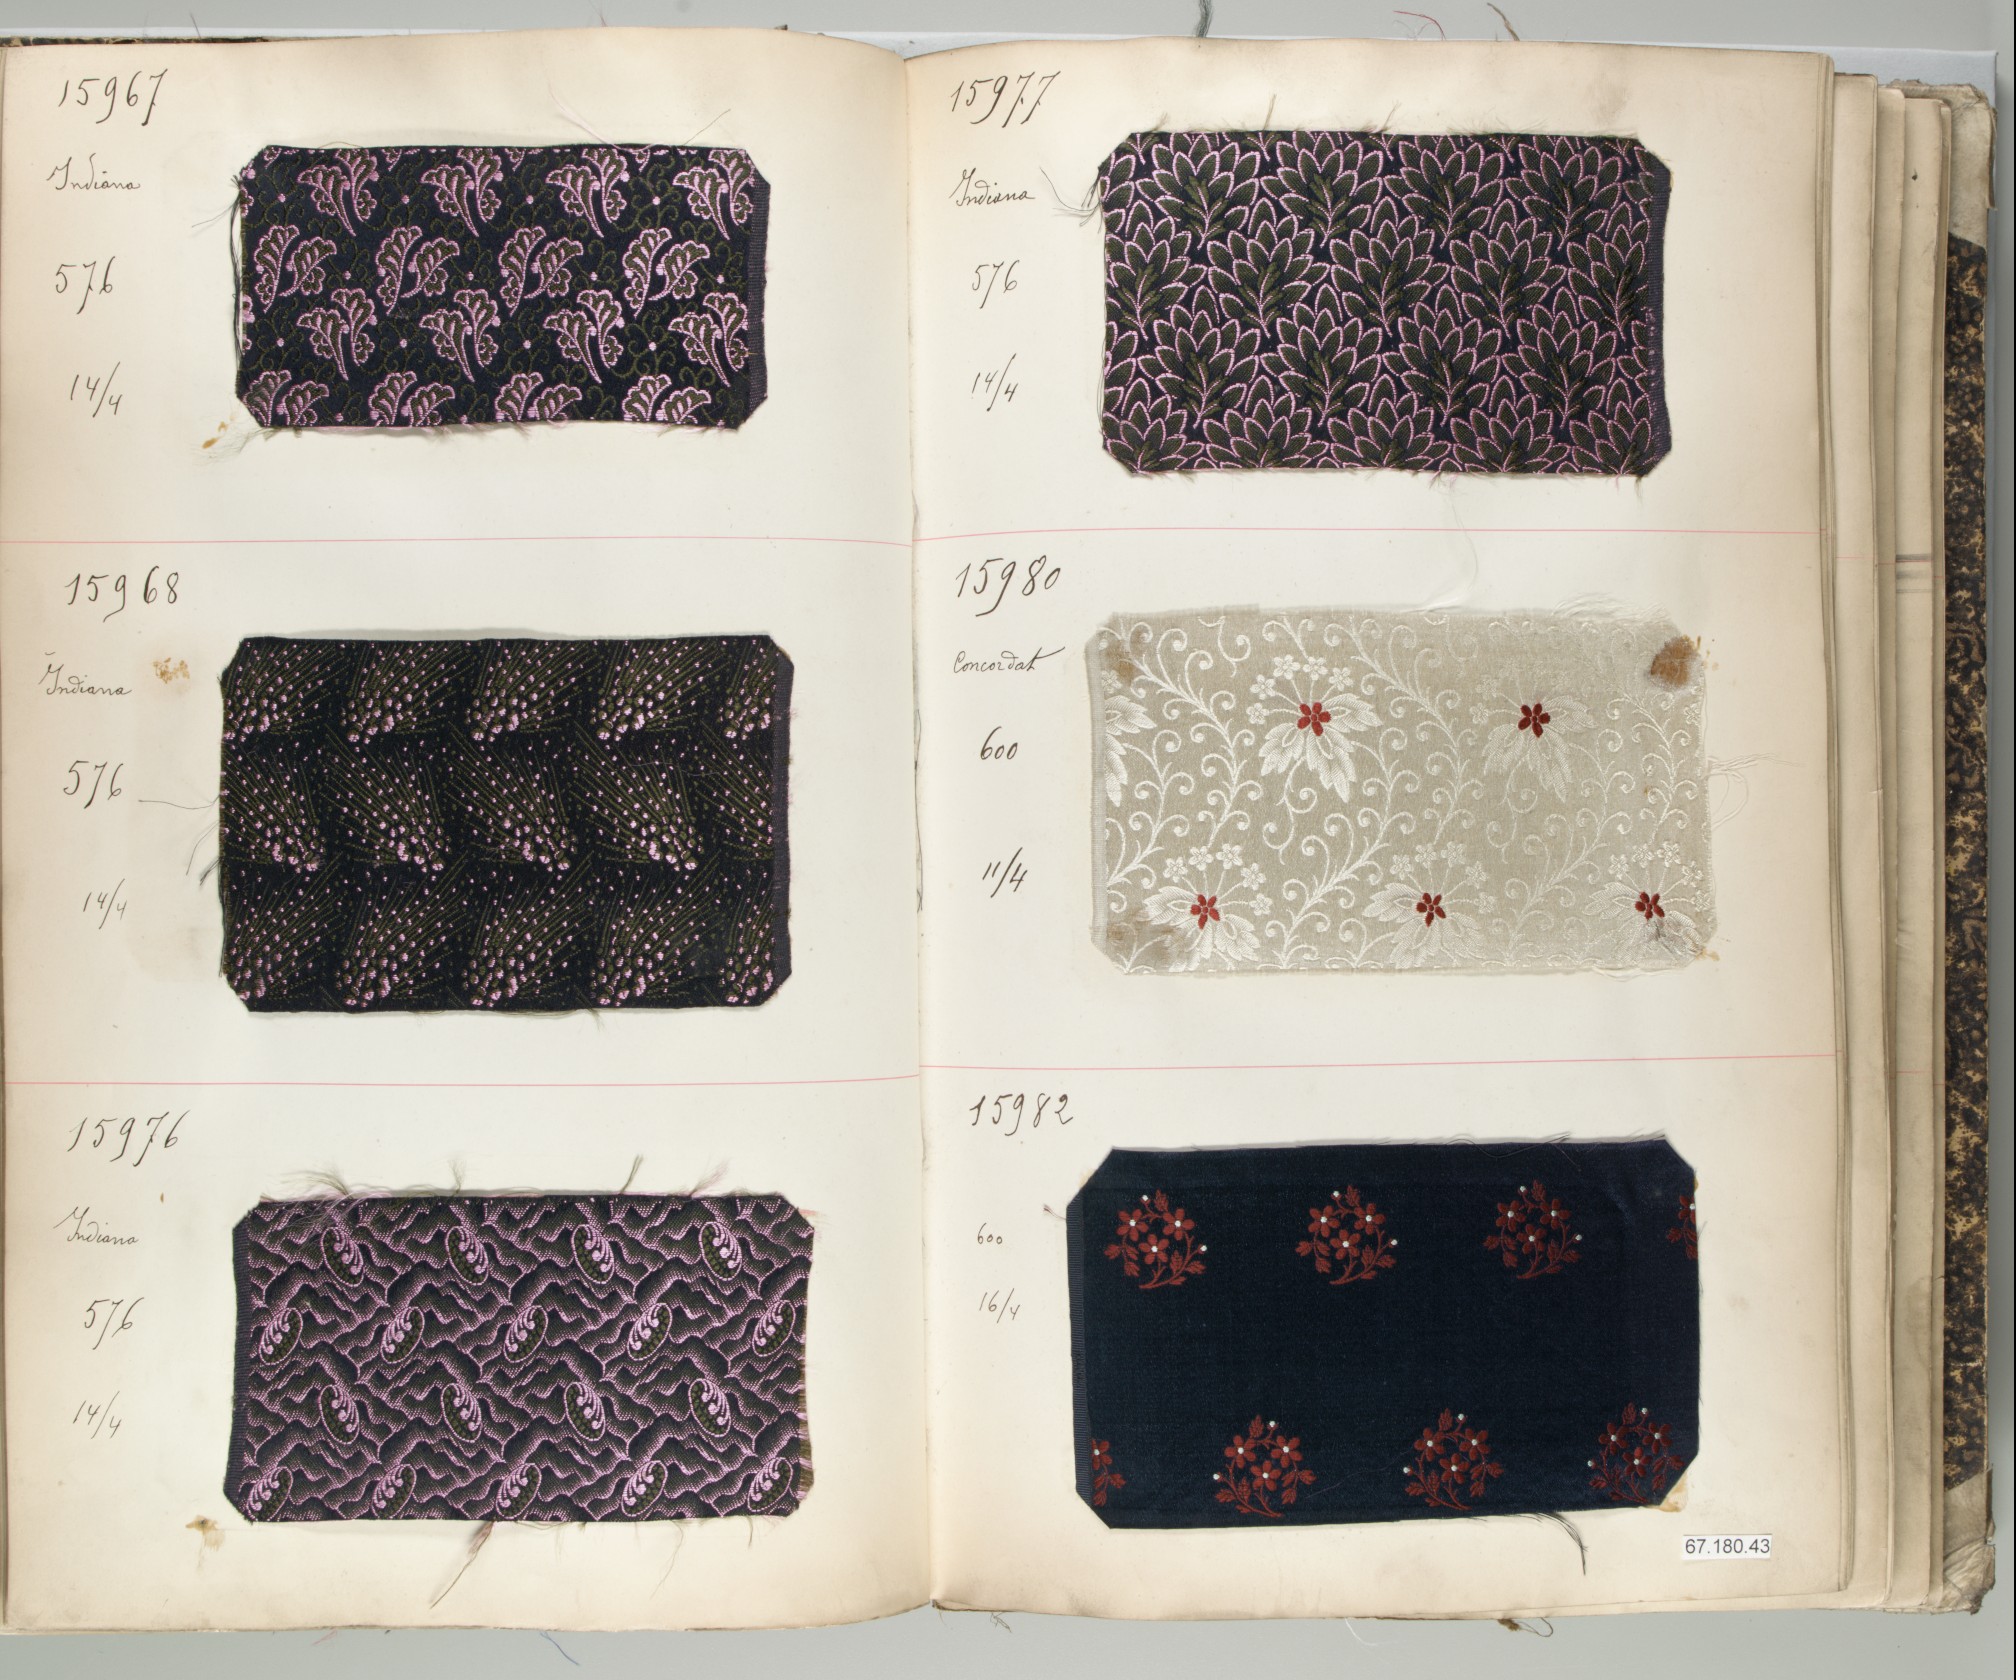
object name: sample book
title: Textile Sample Book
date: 1881